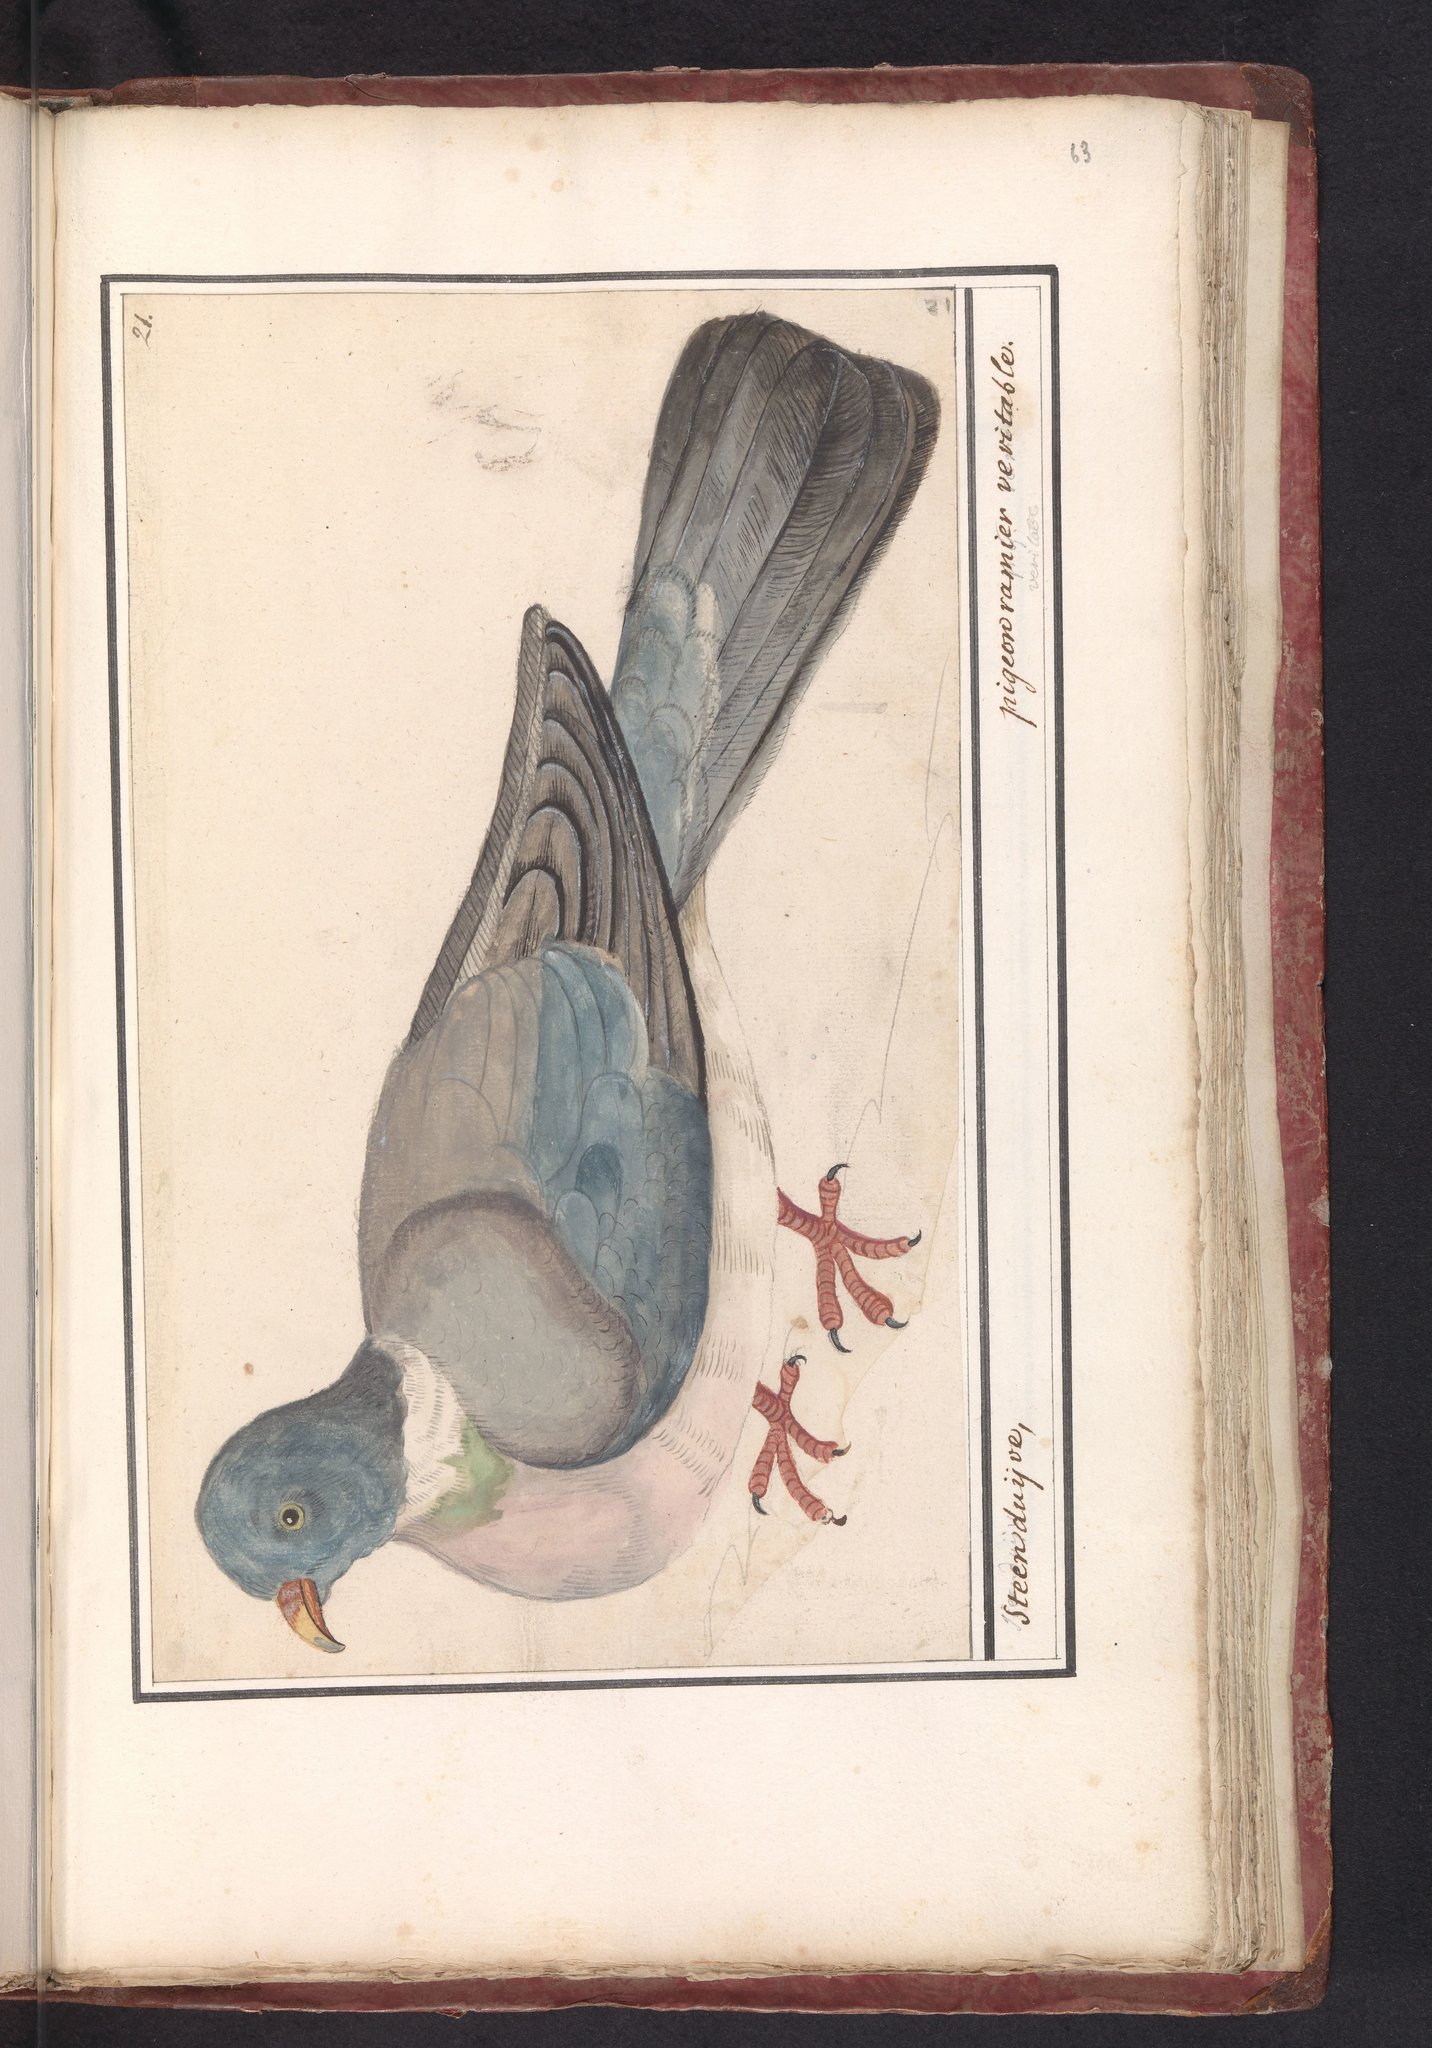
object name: drawing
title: Rock Pigeon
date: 1596-1610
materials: paint, paper, pencil, watercolor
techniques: brush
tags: doves, pigeons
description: Rotsduif. Genummerd rechtsboven: 21. Onderdeel van het eerste album met tekeningen van vogels. Derde van twaalf albums met tekeningen van dieren, vogels en planten bekend rond 1600, gemaakt in opdracht van keizer Rudolf II. Met toelichting in Nederlands, Latijn en Frans.